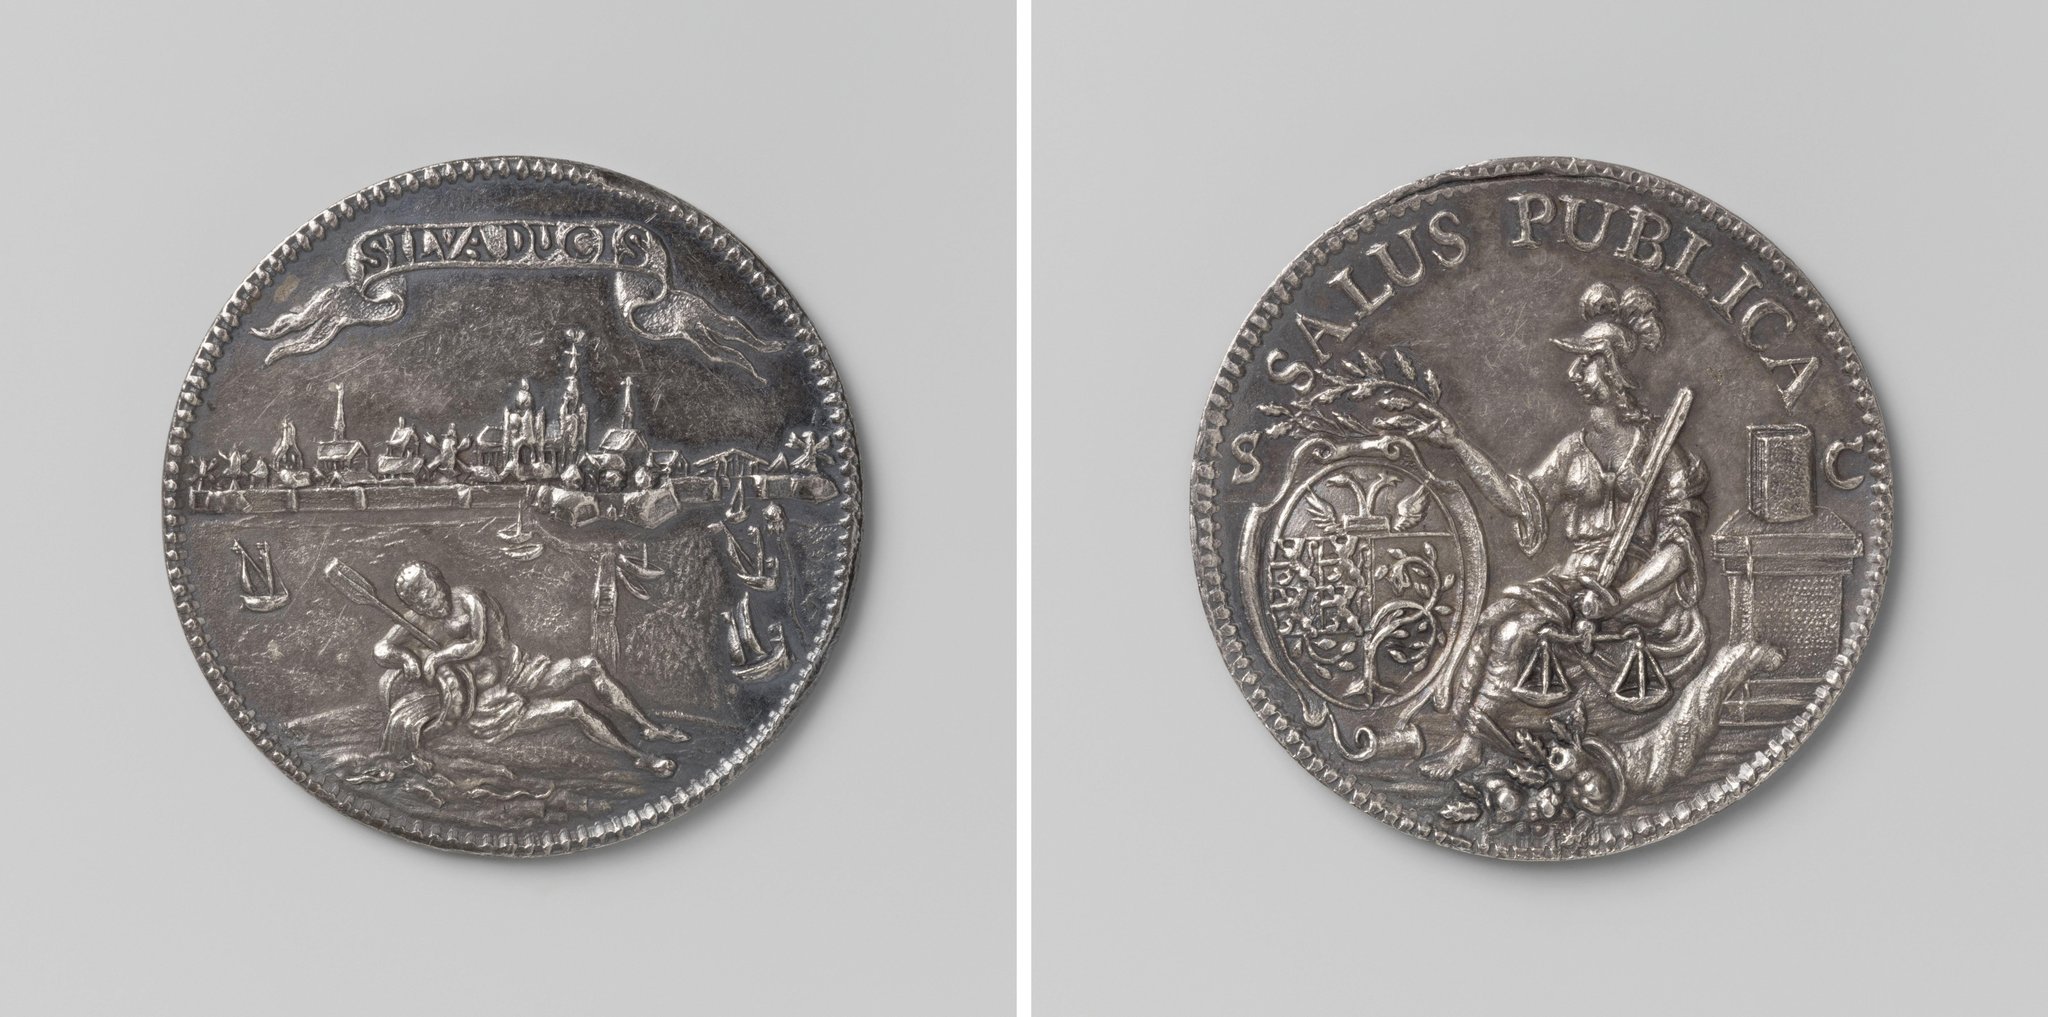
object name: council medal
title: Vroedschapspenning van de stad 's-Hertogenbosch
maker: theodorus casparus van berckel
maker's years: 1680-1734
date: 1712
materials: silver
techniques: striking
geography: den bosch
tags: den bosch